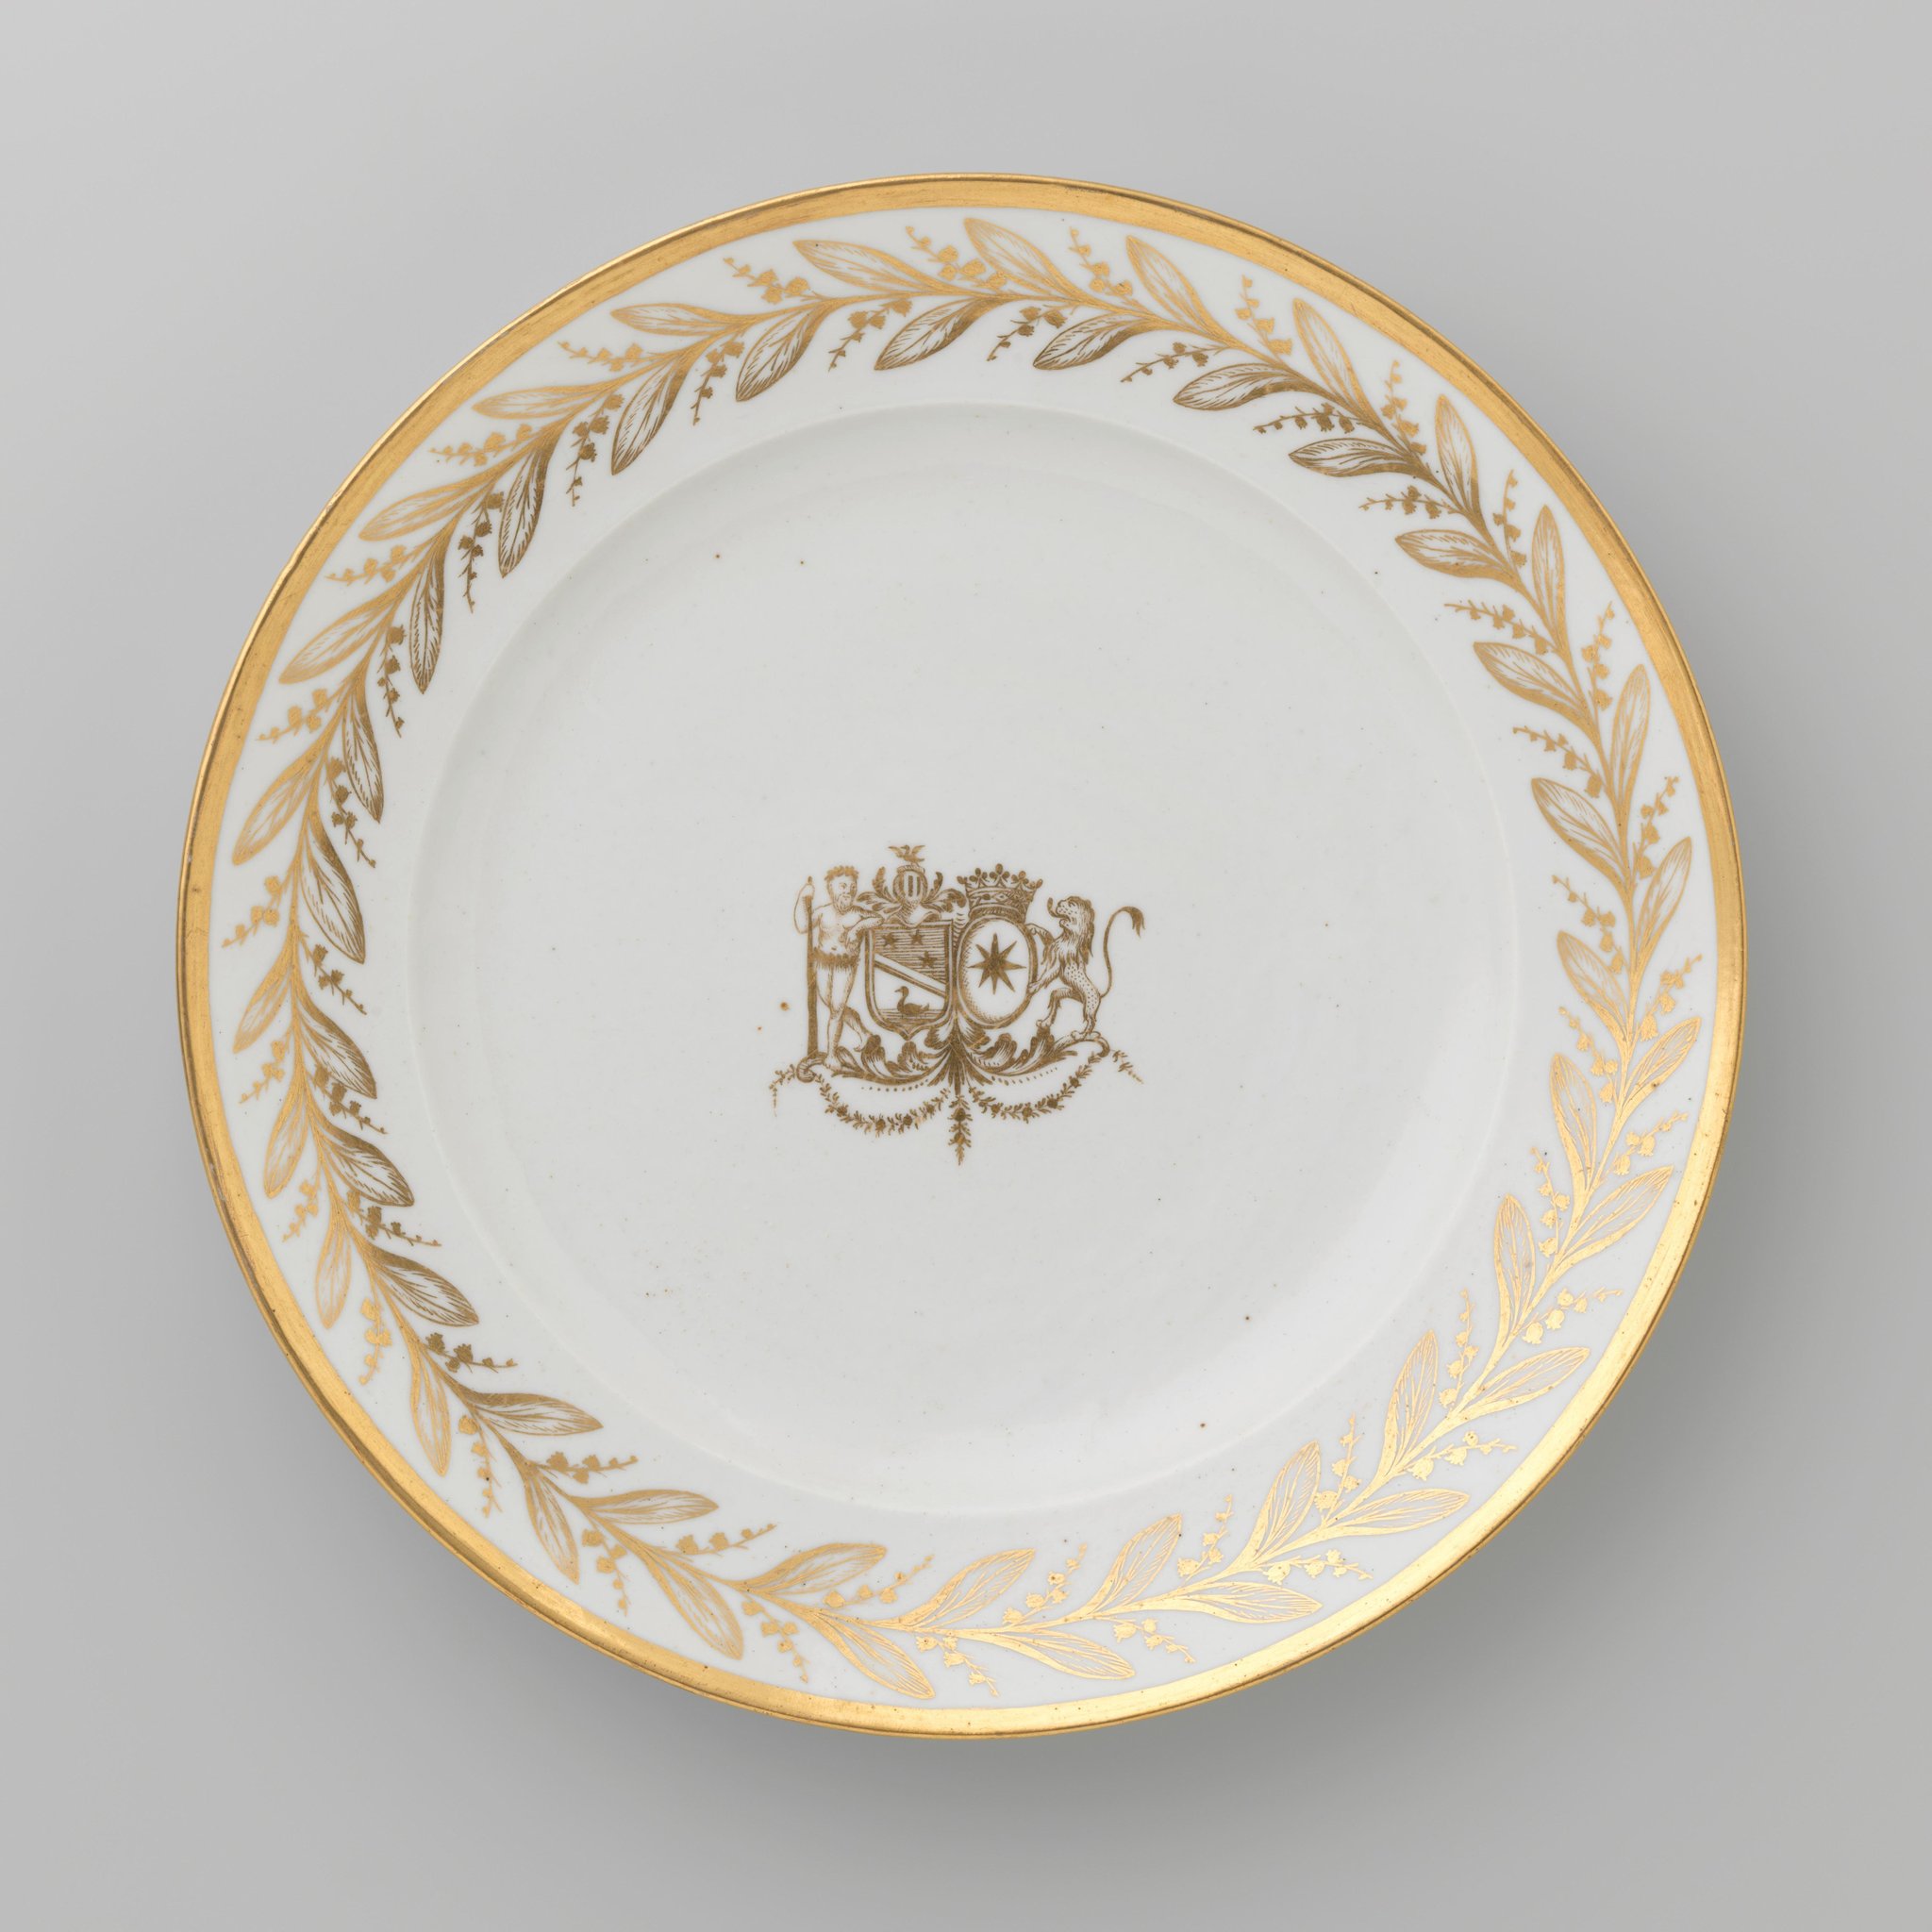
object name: platter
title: Dish with the coat of arms of Hendrik Peter Godfried Quack and Isabella Gertraud von Carnap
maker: Anonymous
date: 1790-1800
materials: glaze, gold, paint, porcelain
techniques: firing, forming, gilding, turning, vitrification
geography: paris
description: Schotel van porselein, beschilderd op het glazuur met goud. Op het plat het alliantiewapen van Hendrik Peter Godfried Quack en Isabella Gertraud von Carnap. De rand met een bloemrank en een gouden band. Dubbele voetring.